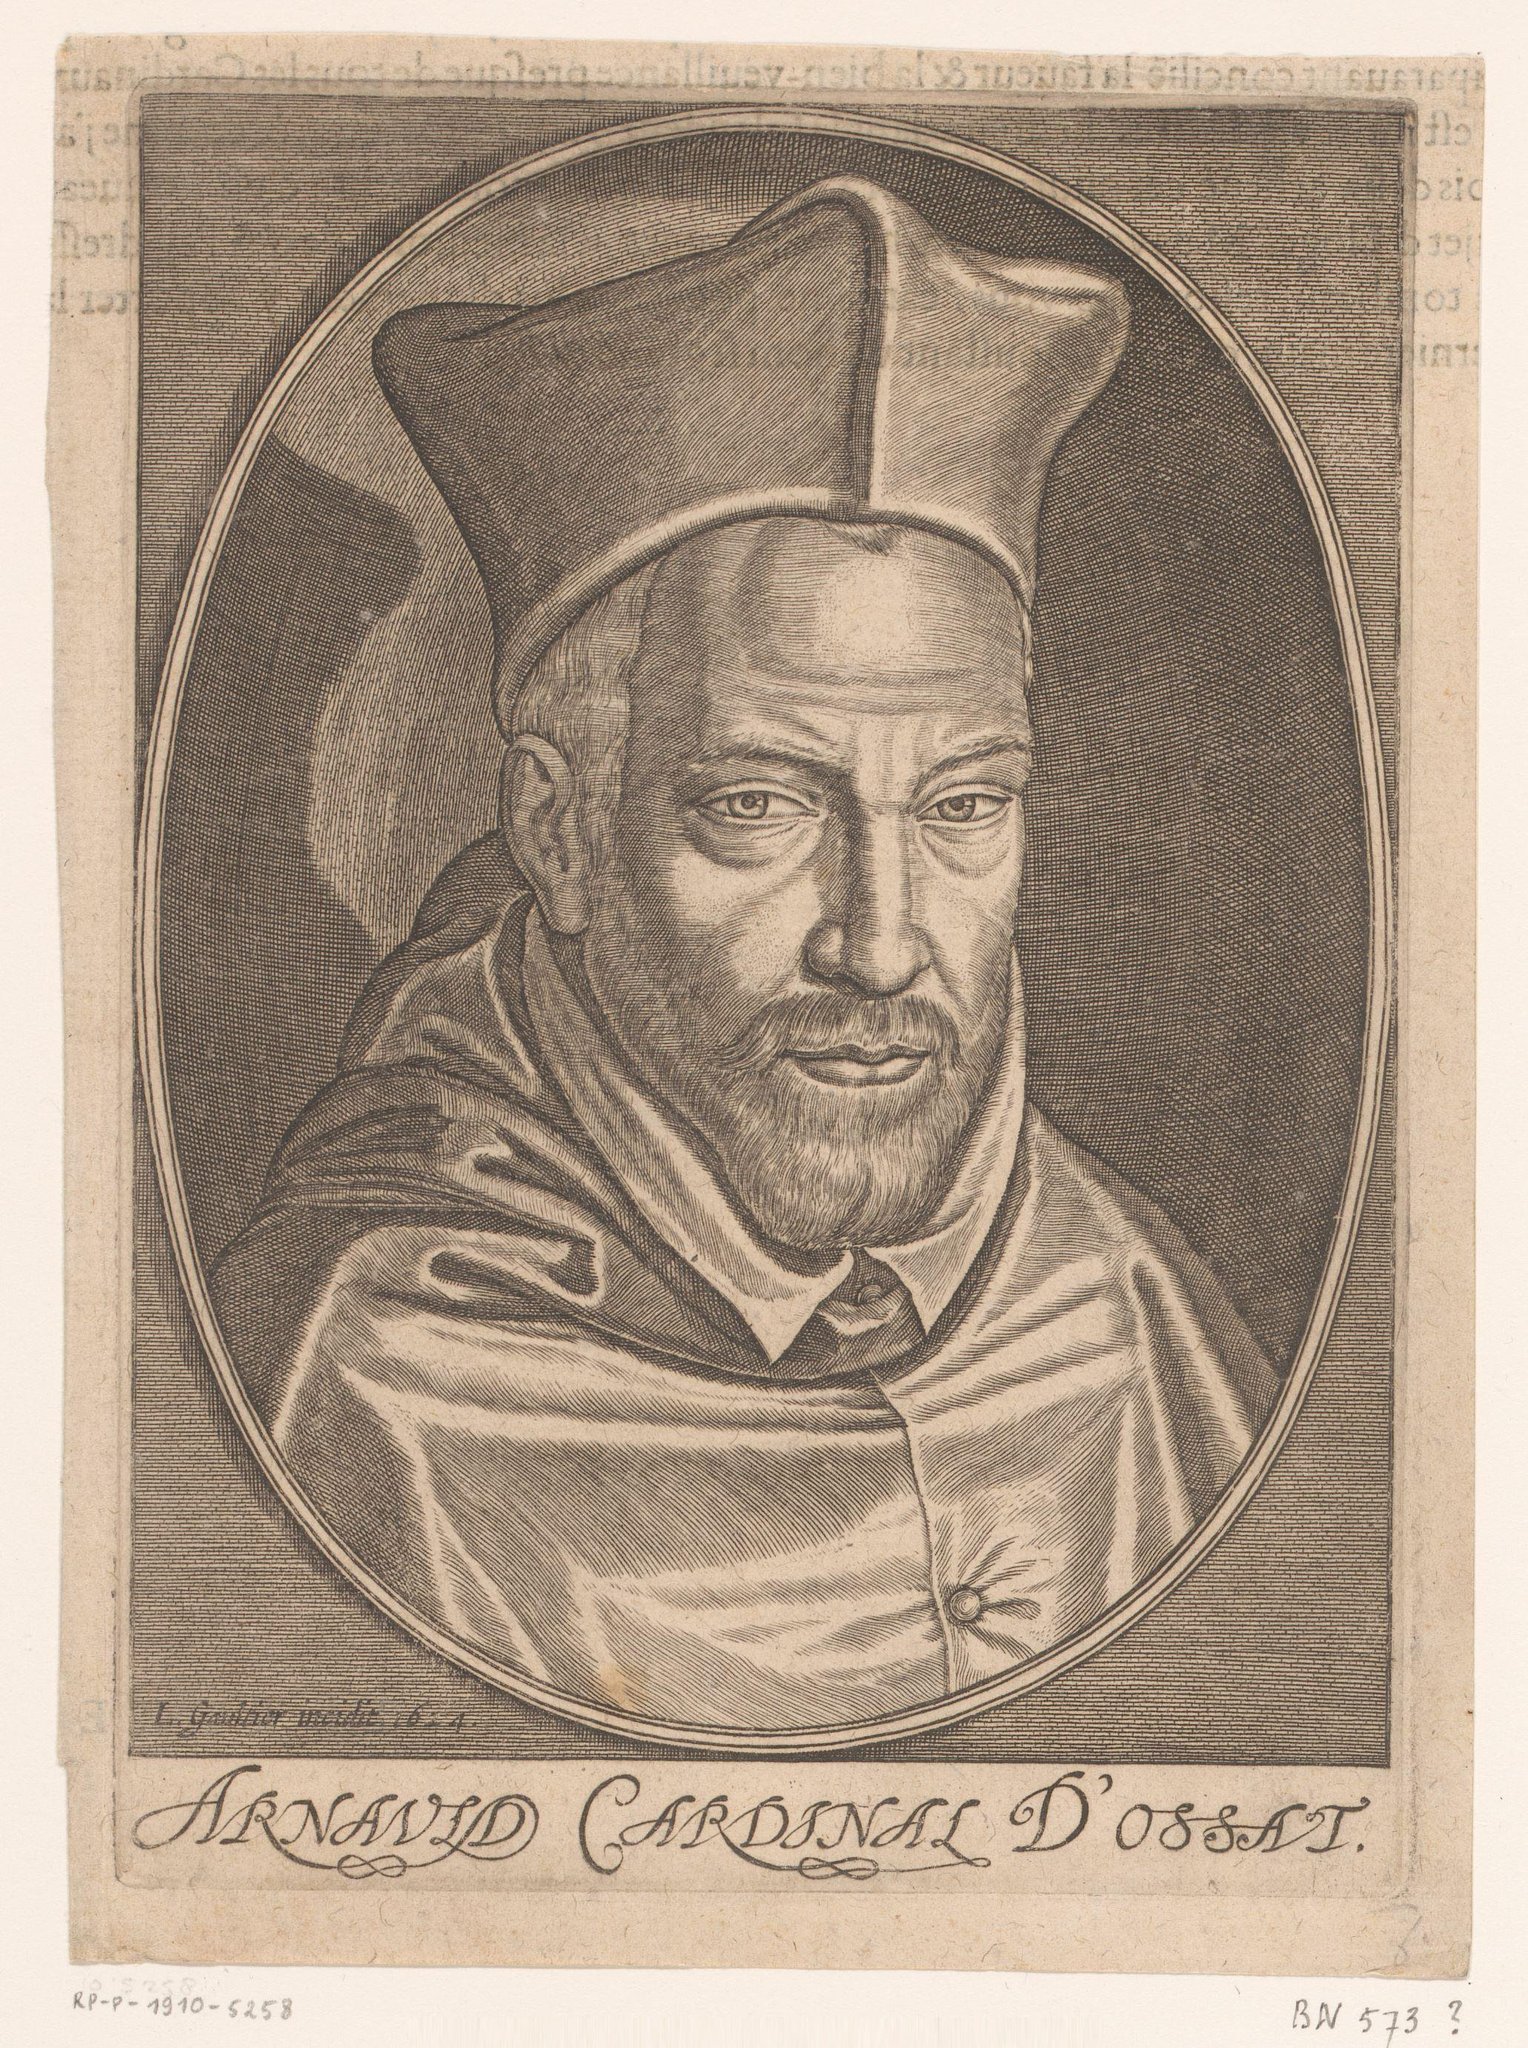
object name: book illustration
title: Arnauld Cardinal D'Ossat.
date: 1624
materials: paper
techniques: engraving, letterpress printing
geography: paris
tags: france, rome, ornament ~ medallion, historical persons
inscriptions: collector's mark: Lugt 2228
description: Prent uit: D'Ossat, Arnaud. Lettres de l'illustrissime et reverendissime cardinal d'Ossat (...) au roy Henri le grand (...). Parijs: Joseph Bouillerot, 1624.